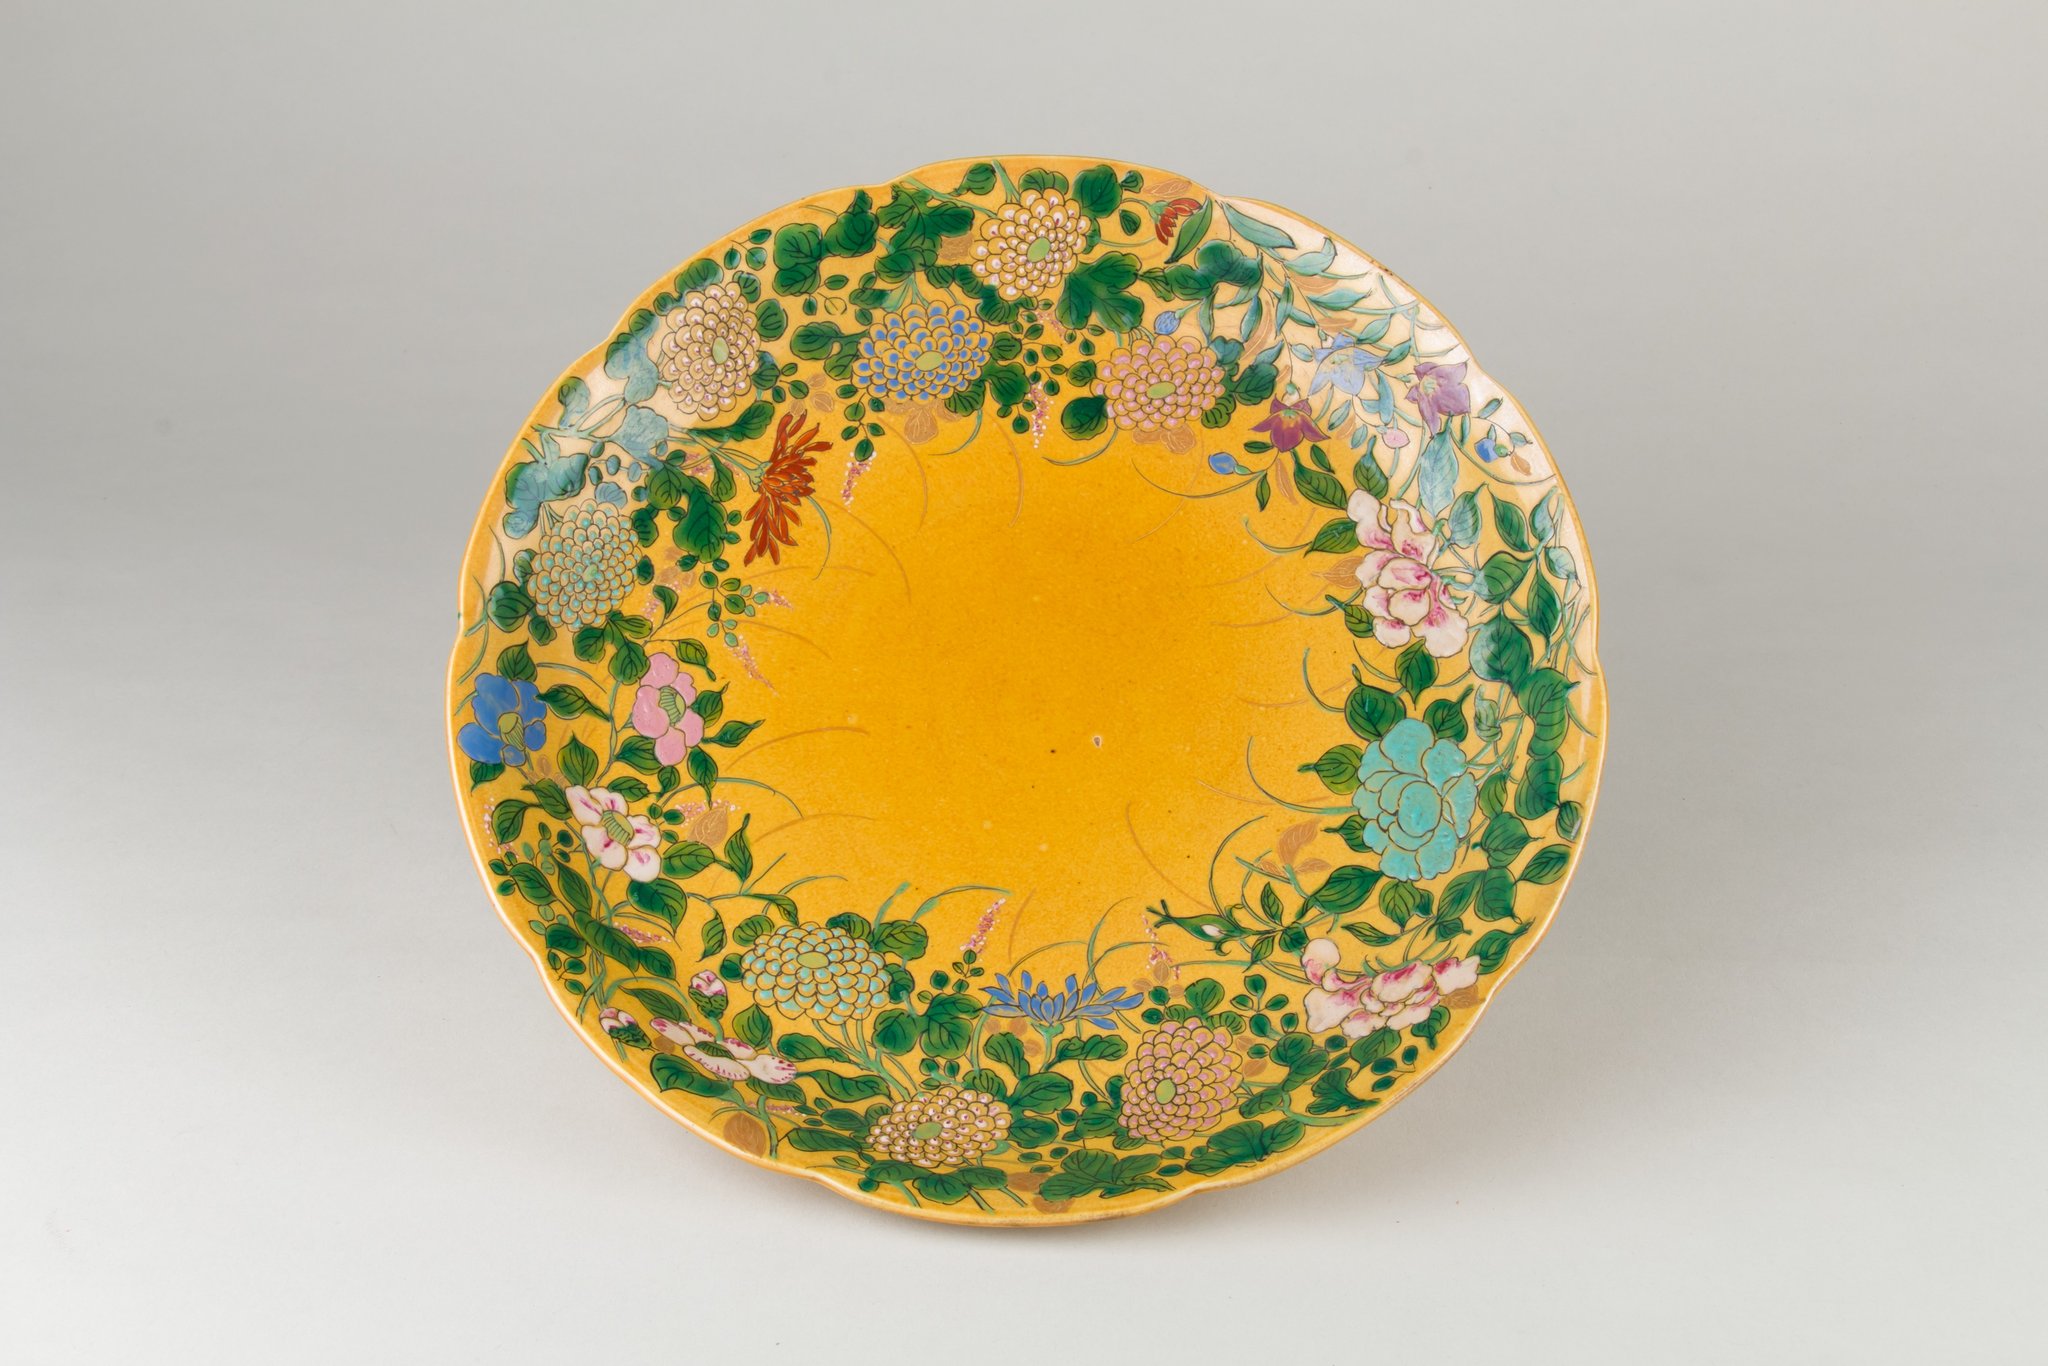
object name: dish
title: Dish with flowers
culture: chinese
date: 1767-1800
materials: enamel, glaze, porcelain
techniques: painting, polychrome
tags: flowers,leaves